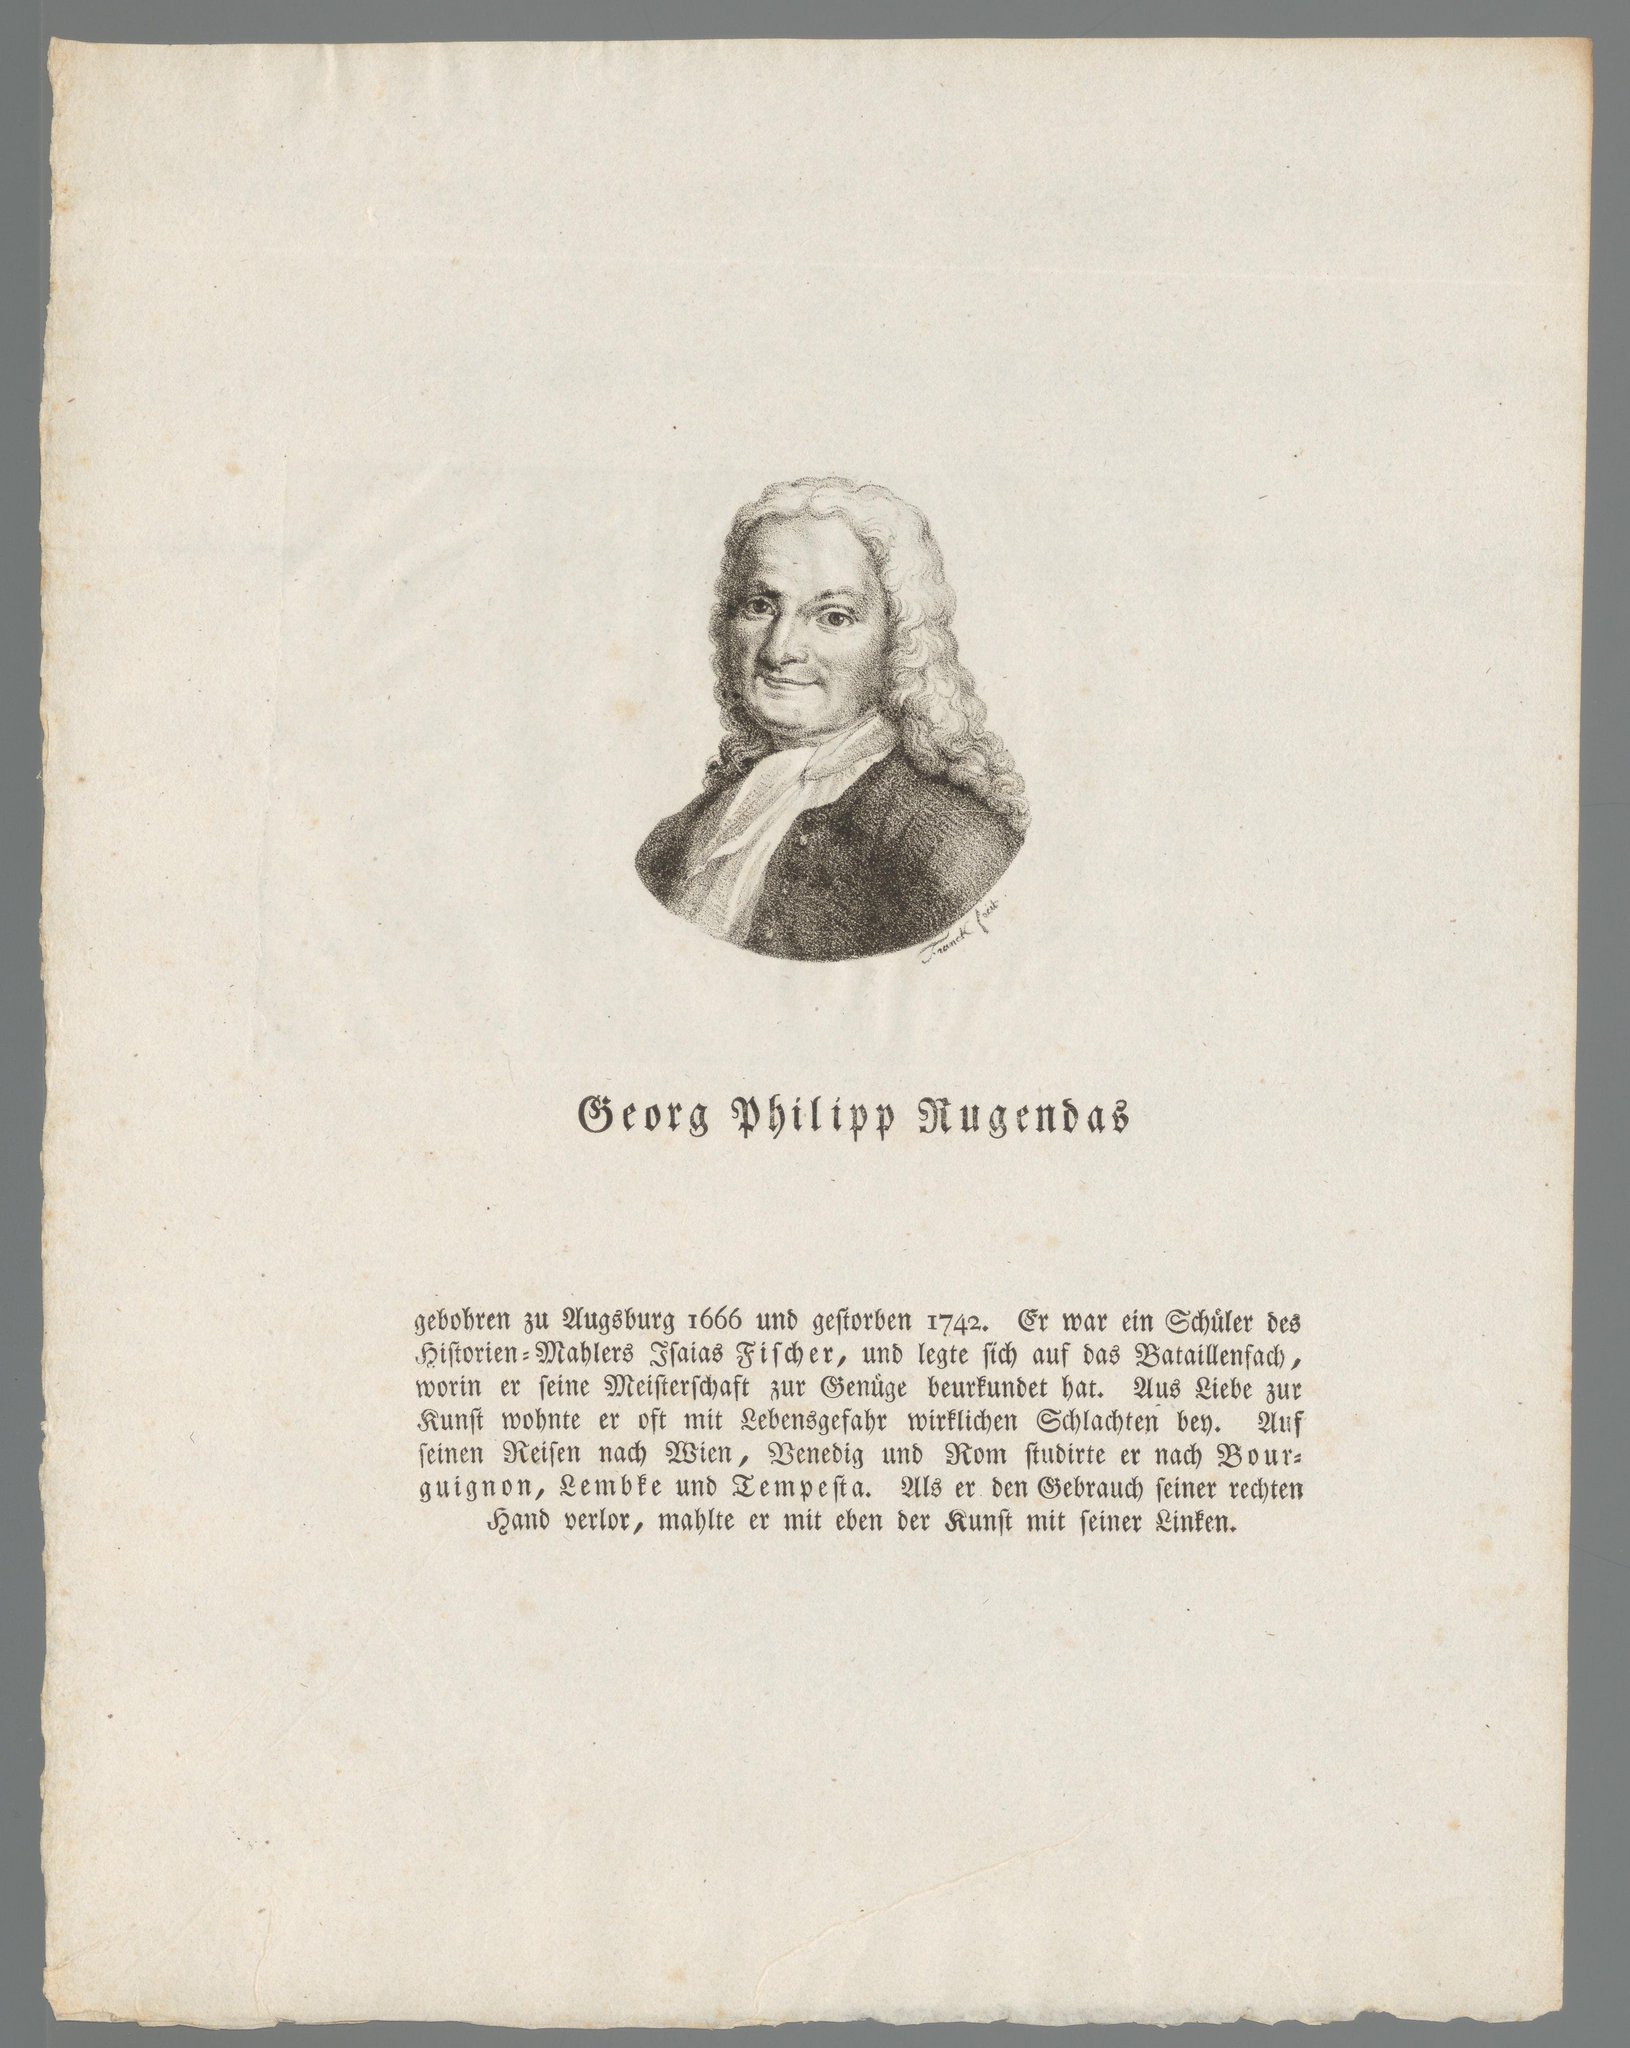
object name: print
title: Portret van Georg Philipp Rugendas (I)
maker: maximilian franck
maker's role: print maker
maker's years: 1780-1830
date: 1813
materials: paper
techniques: letterpress printing, lithograph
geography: munich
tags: augsburg, print maker, draughtsman, publisher, georg philipp rugendas (i), historical persons, portrait, self-portrait of painter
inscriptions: collector's mark: Lugt 2228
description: Prent uit: Lindauer, Joseph. Deutsche Künstler-Gallerie. München: Maximilian Franck, 1813.